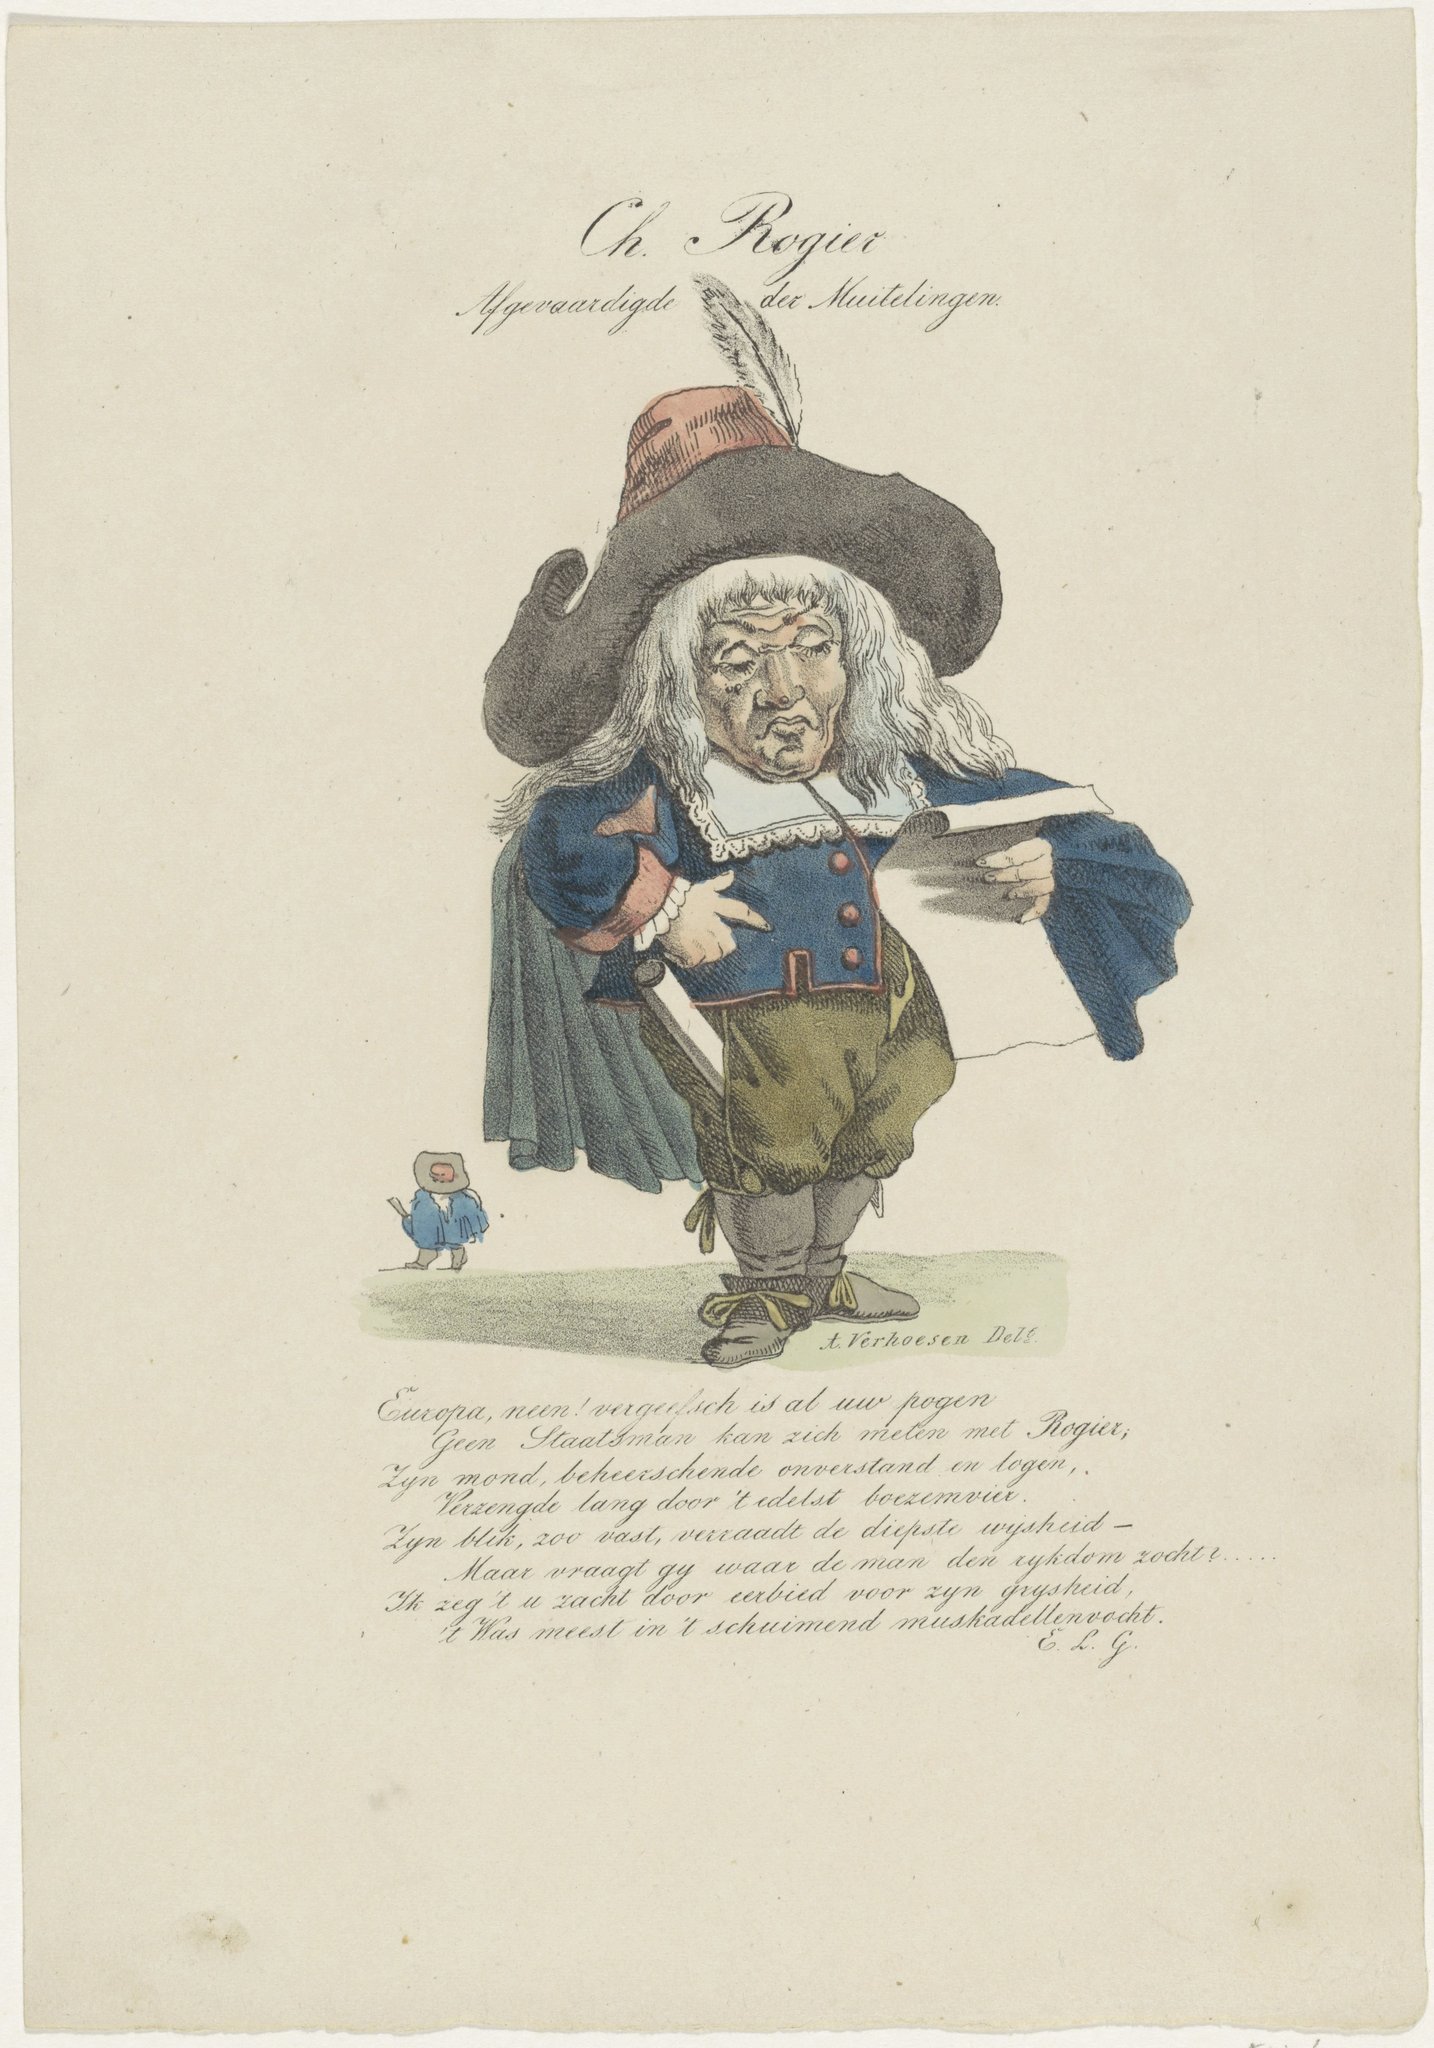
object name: print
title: Spotprent op Charles Rogier, ca. 1830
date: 1830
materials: paper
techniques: hand coloring, lithograph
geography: netherlands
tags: politician, revolutionary government, little people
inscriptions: collector's mark: Lugt 2228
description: Spotprent op de verschillende leden van het Voorlopig Bewind van België in 1830. Charles Rogier als Afgevaardigde der Muitelingen, voorgesteld als een kleine mens (karikatuur) met lang haar en een grote hoed met veer, een document lezend. Met achtregelig versje.